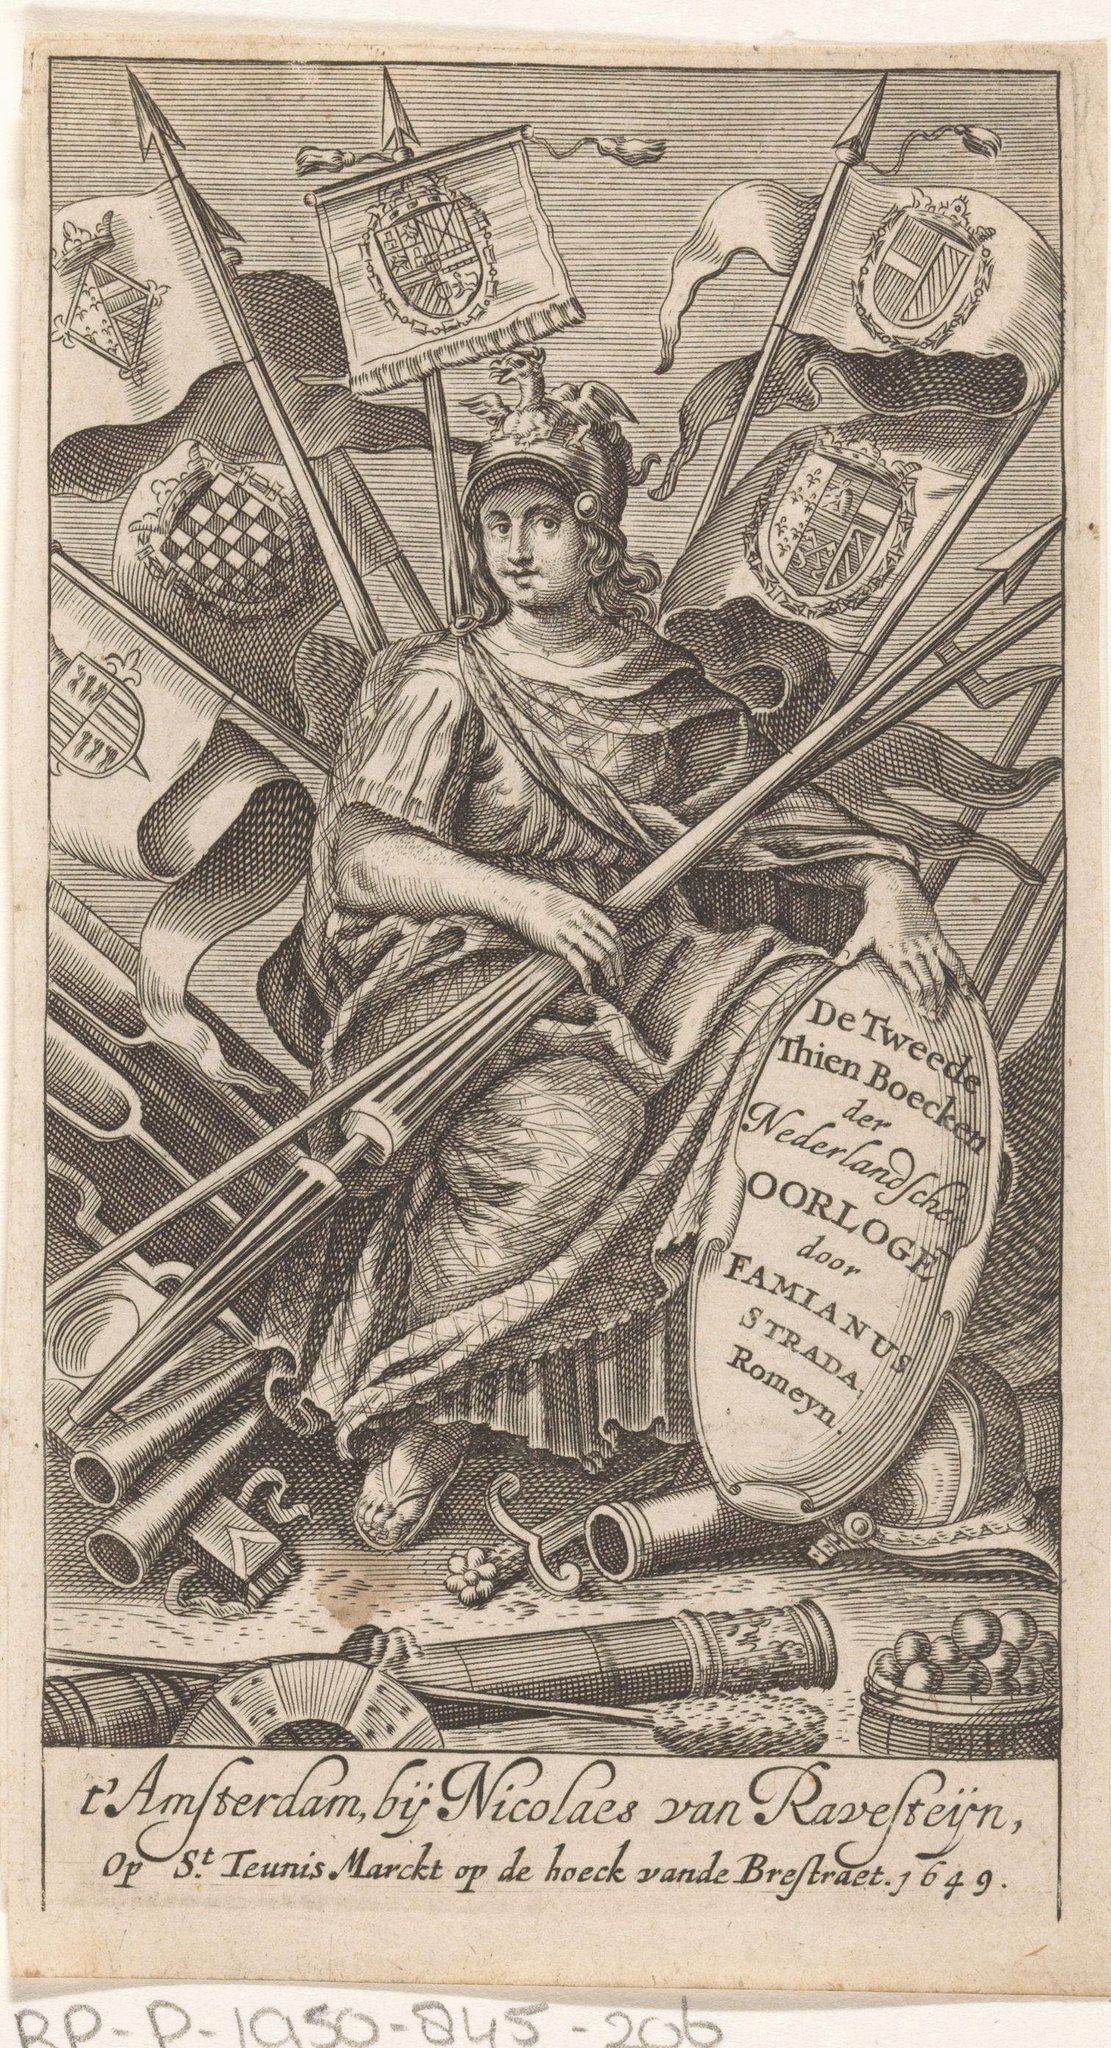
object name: titelblad, titelpagina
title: Titelpagina voor: Famiano Strada, Het Tweede Deel Der Nederlandsche oorlogen, 1649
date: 1649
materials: paper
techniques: engraving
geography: amsterdam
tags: sitting figure - aa - female human figure, weapons, (military) flags and standards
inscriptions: collector's mark: Lugt 2760, collector's mark: Lugt 2228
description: Titelpagina voor: Strada, Famiano. Het Tweede Deel Der Nederlandsche oorlogen. Amsterdam: Ravesteyn, Nicolaes van, 1649. Prent afkomstig uit een plakalbum met titelprenten, ornamenten etc. op blauw papier in 1983 uit elkaar gehaald. Volgens een notitie op verso zat de prent op p. 206 van dit album.